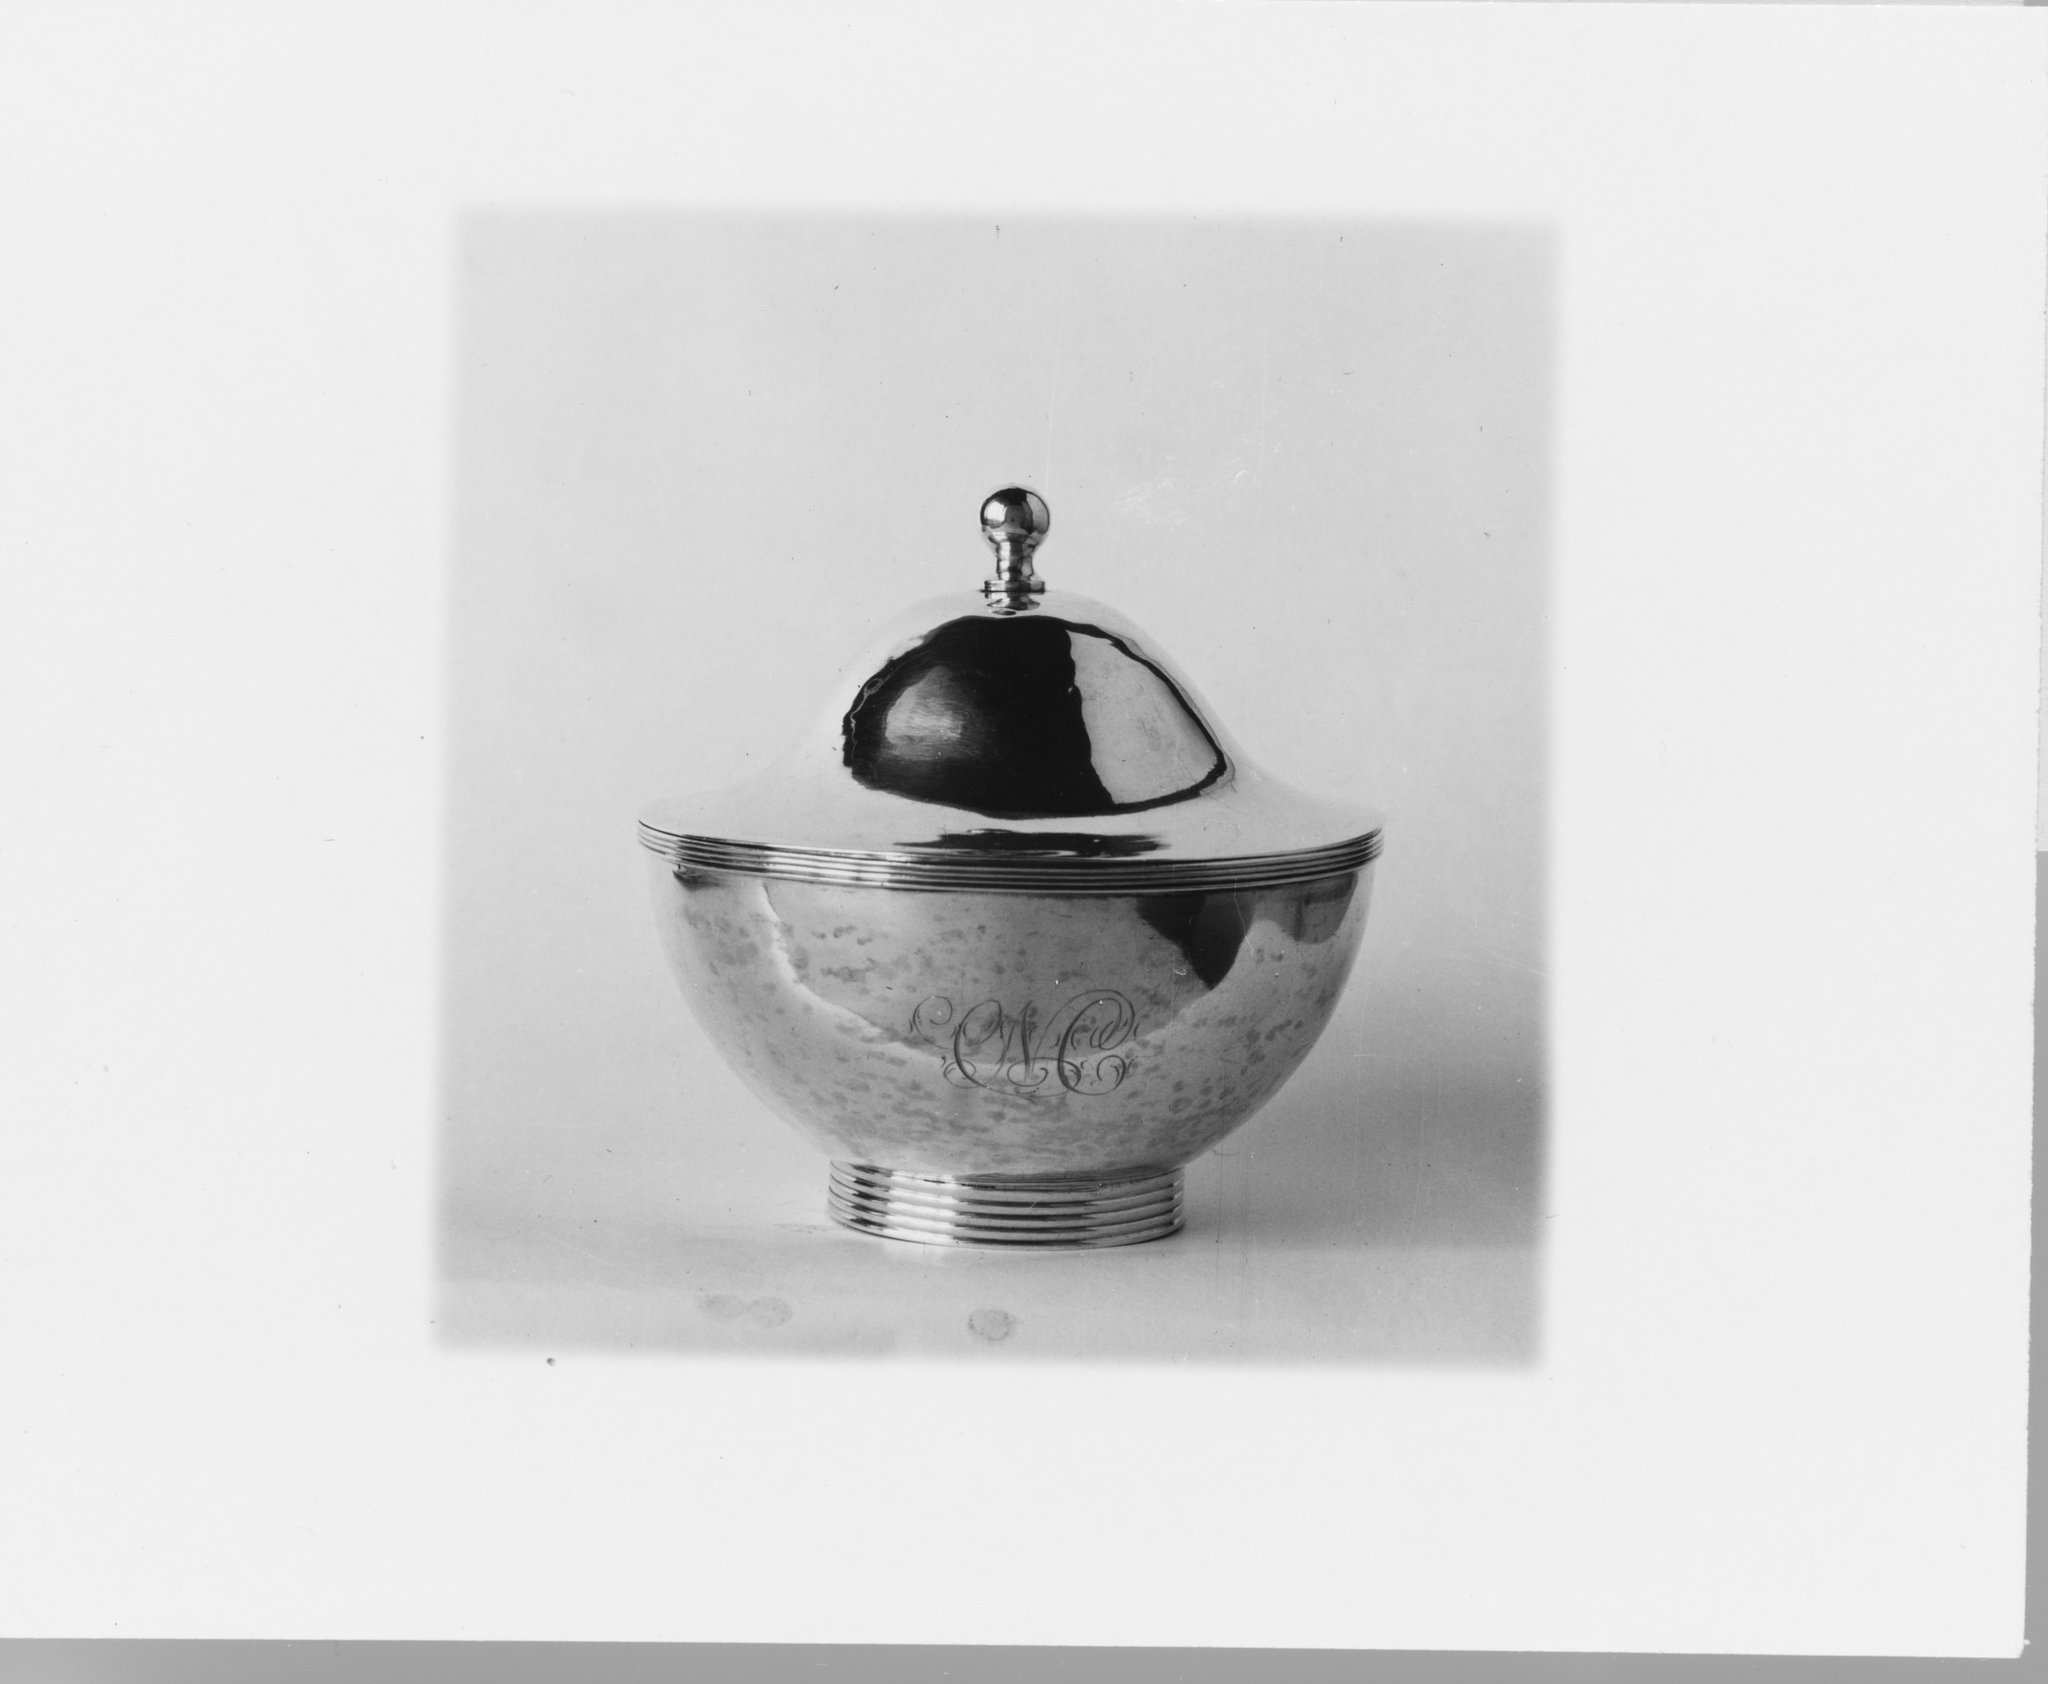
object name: sugar bowl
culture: american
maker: ebenezer moulton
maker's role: maker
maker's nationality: american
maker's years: 1768-1824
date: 1810-1820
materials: silver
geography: united states